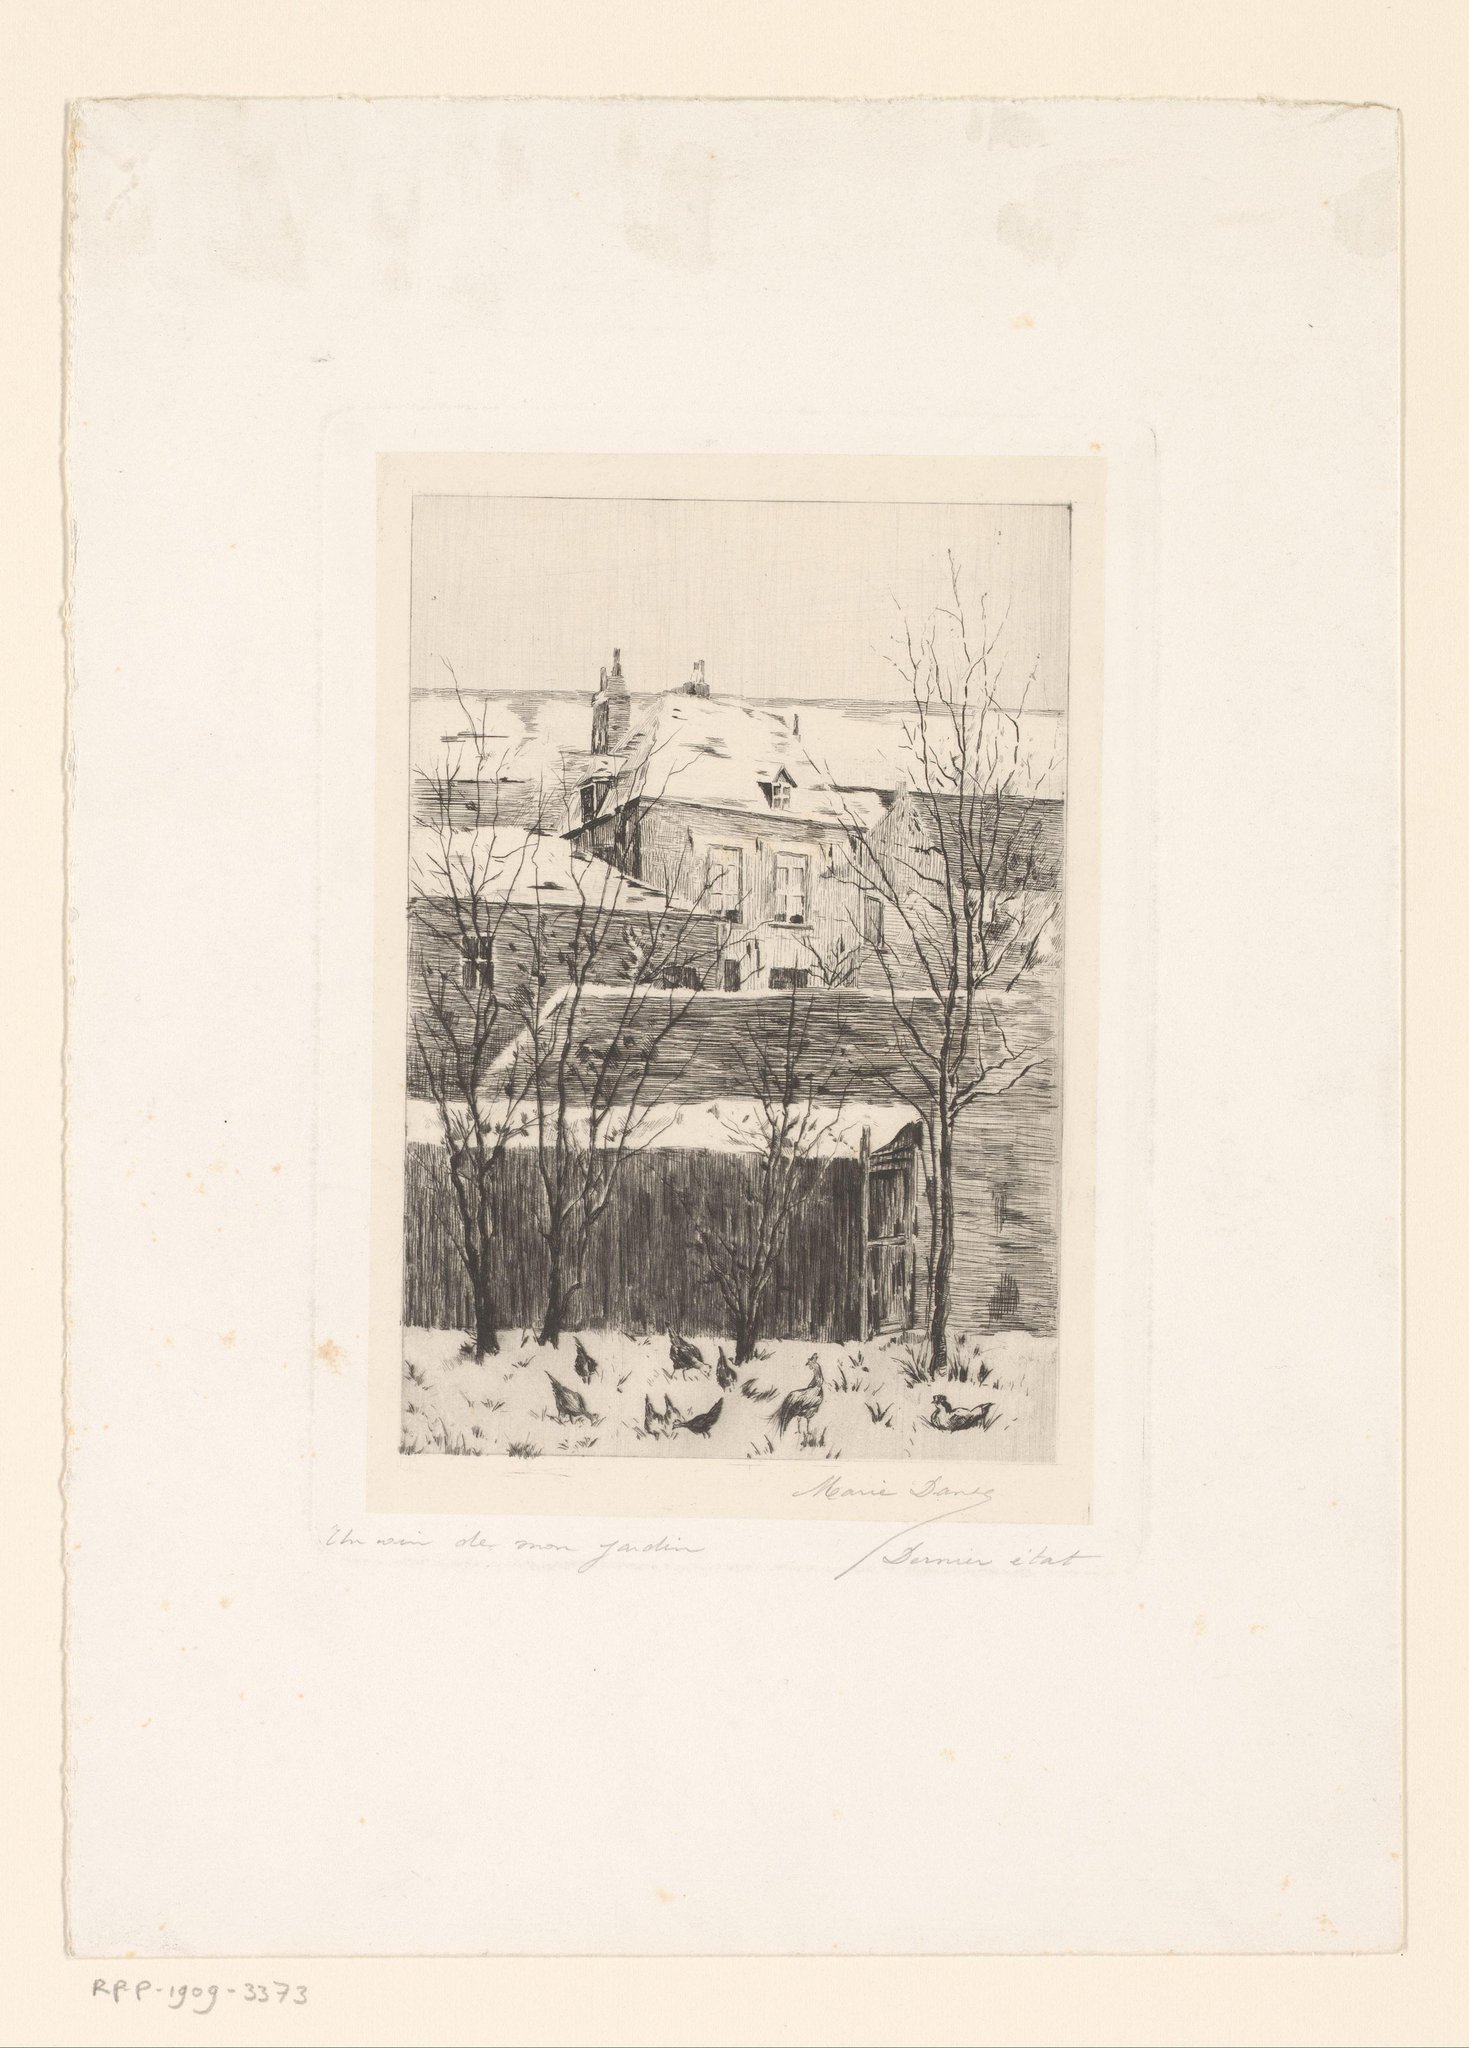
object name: print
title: Gezicht op een gedeelte van de tuin van Marie Danse met huizen op de achtergrond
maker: marie danse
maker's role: print maker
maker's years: 1867-1942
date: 1877-1909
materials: paper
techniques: drypoint, etching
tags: brussels, print maker, marie danse, garden, chicken house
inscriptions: inscription: ‘Un coin de mon jardin; Dernier état’, collector's mark: Lugt 2228